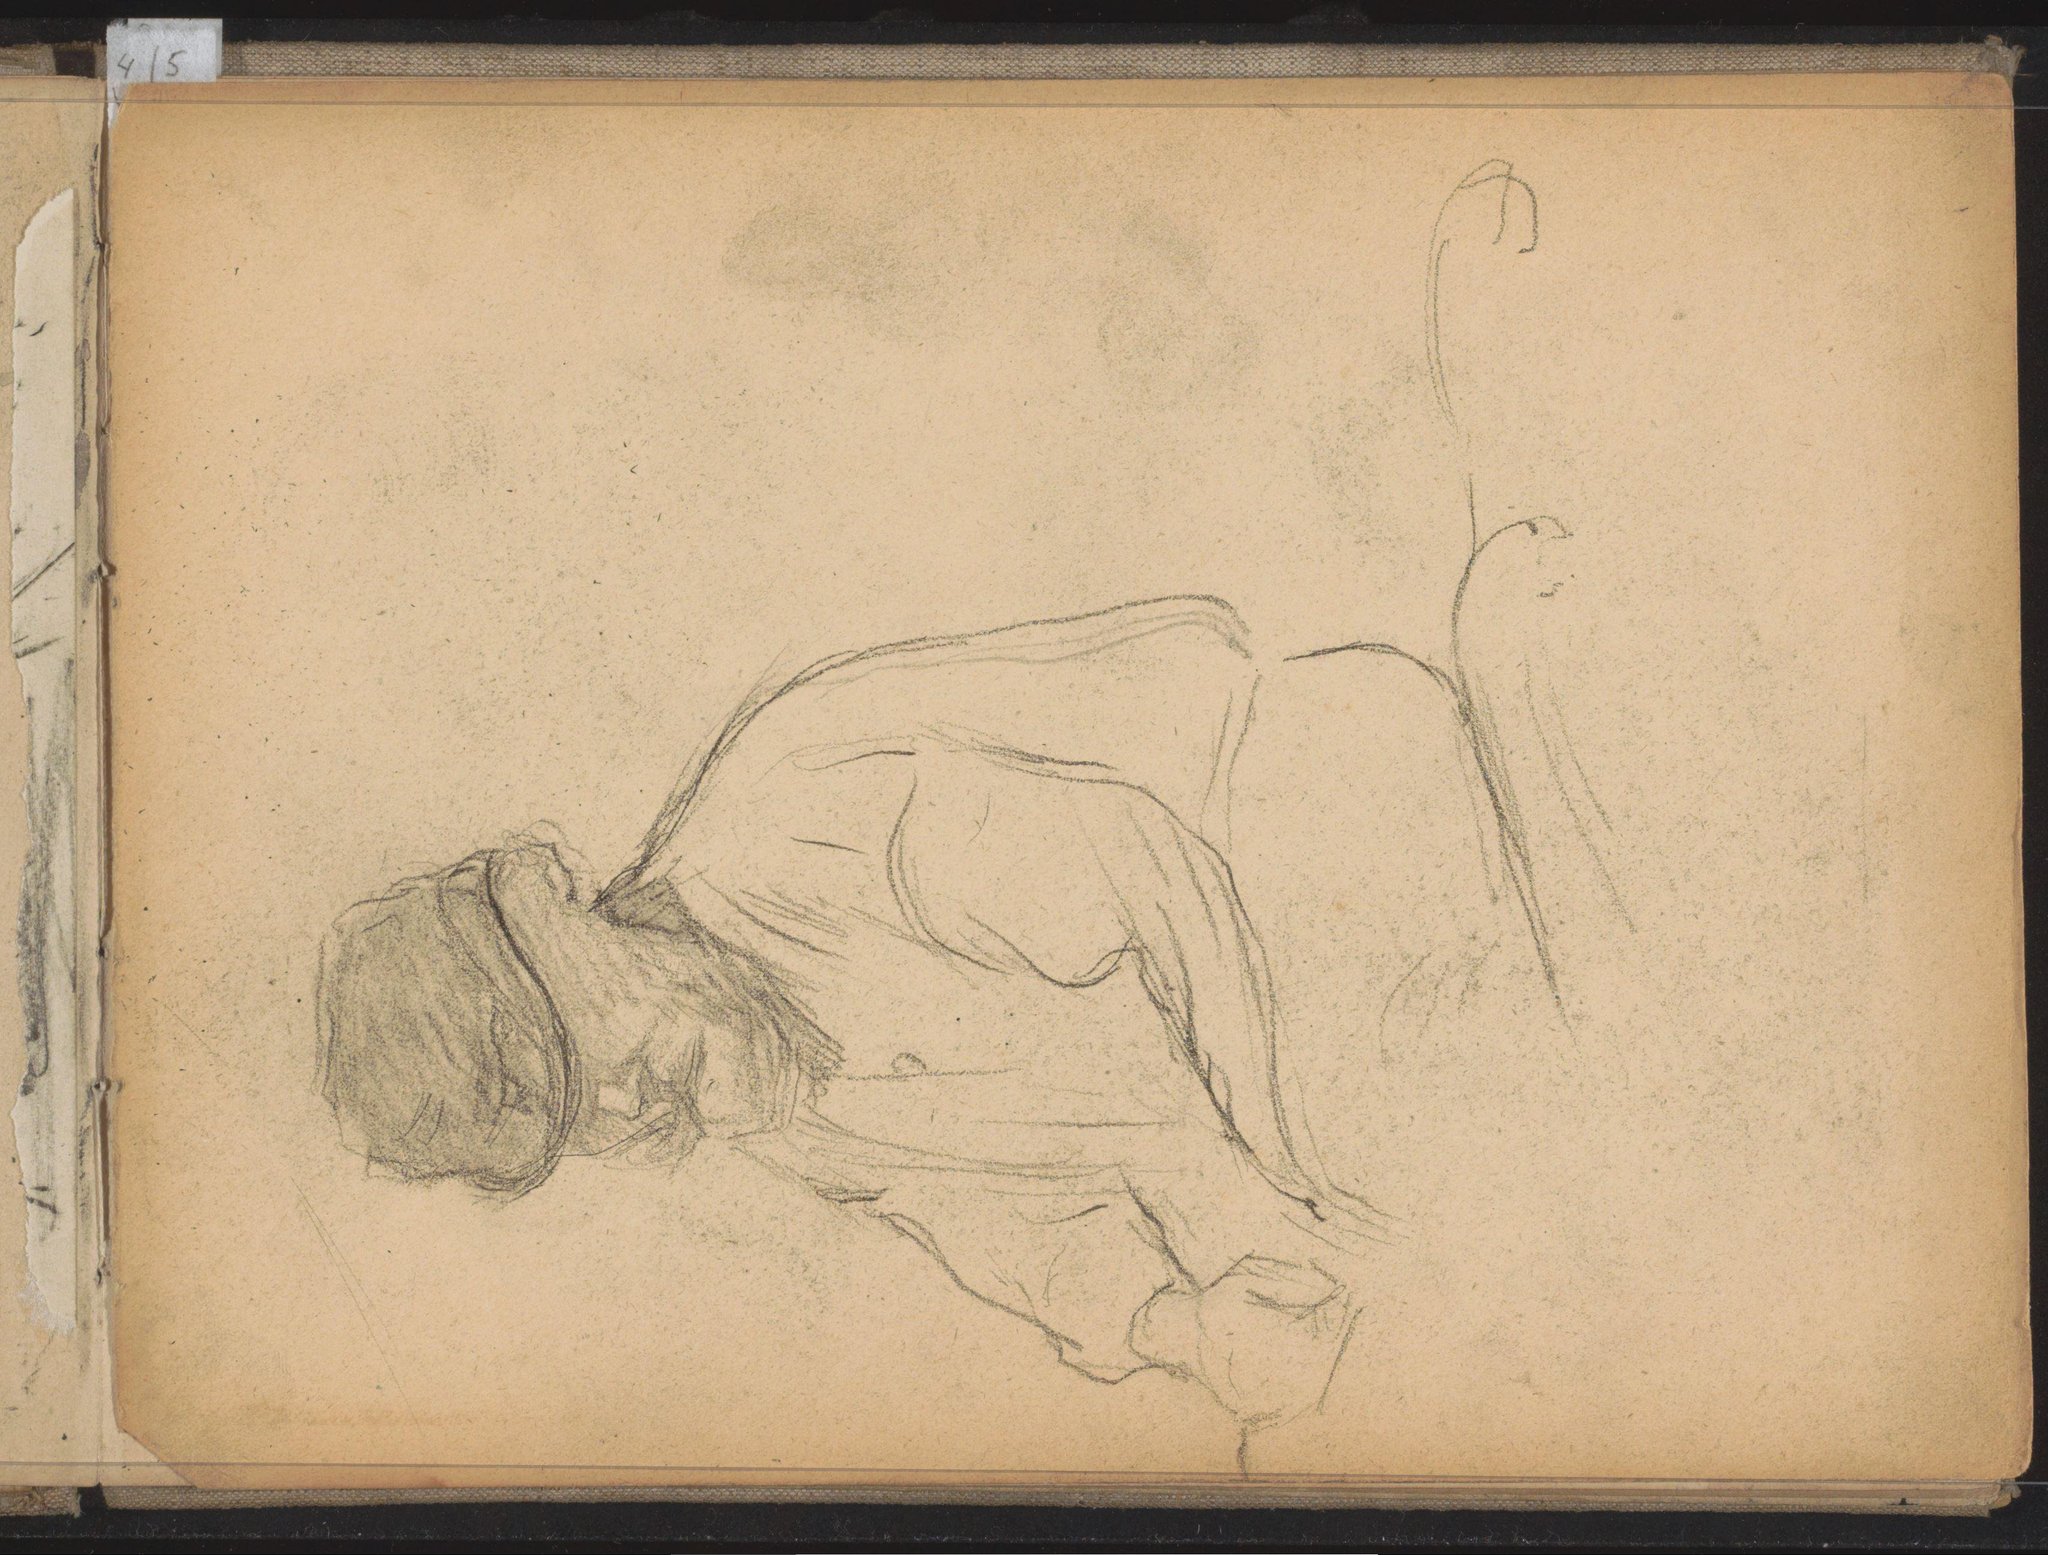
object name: sketchbook leaf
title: Zittende man met een snor en hoed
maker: johanna van de kamer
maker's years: 1873-1922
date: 1890-1922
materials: chalk, paper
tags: sitting figure, moustache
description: Blad 4 recto uit een schetsboek met 11 bladen.